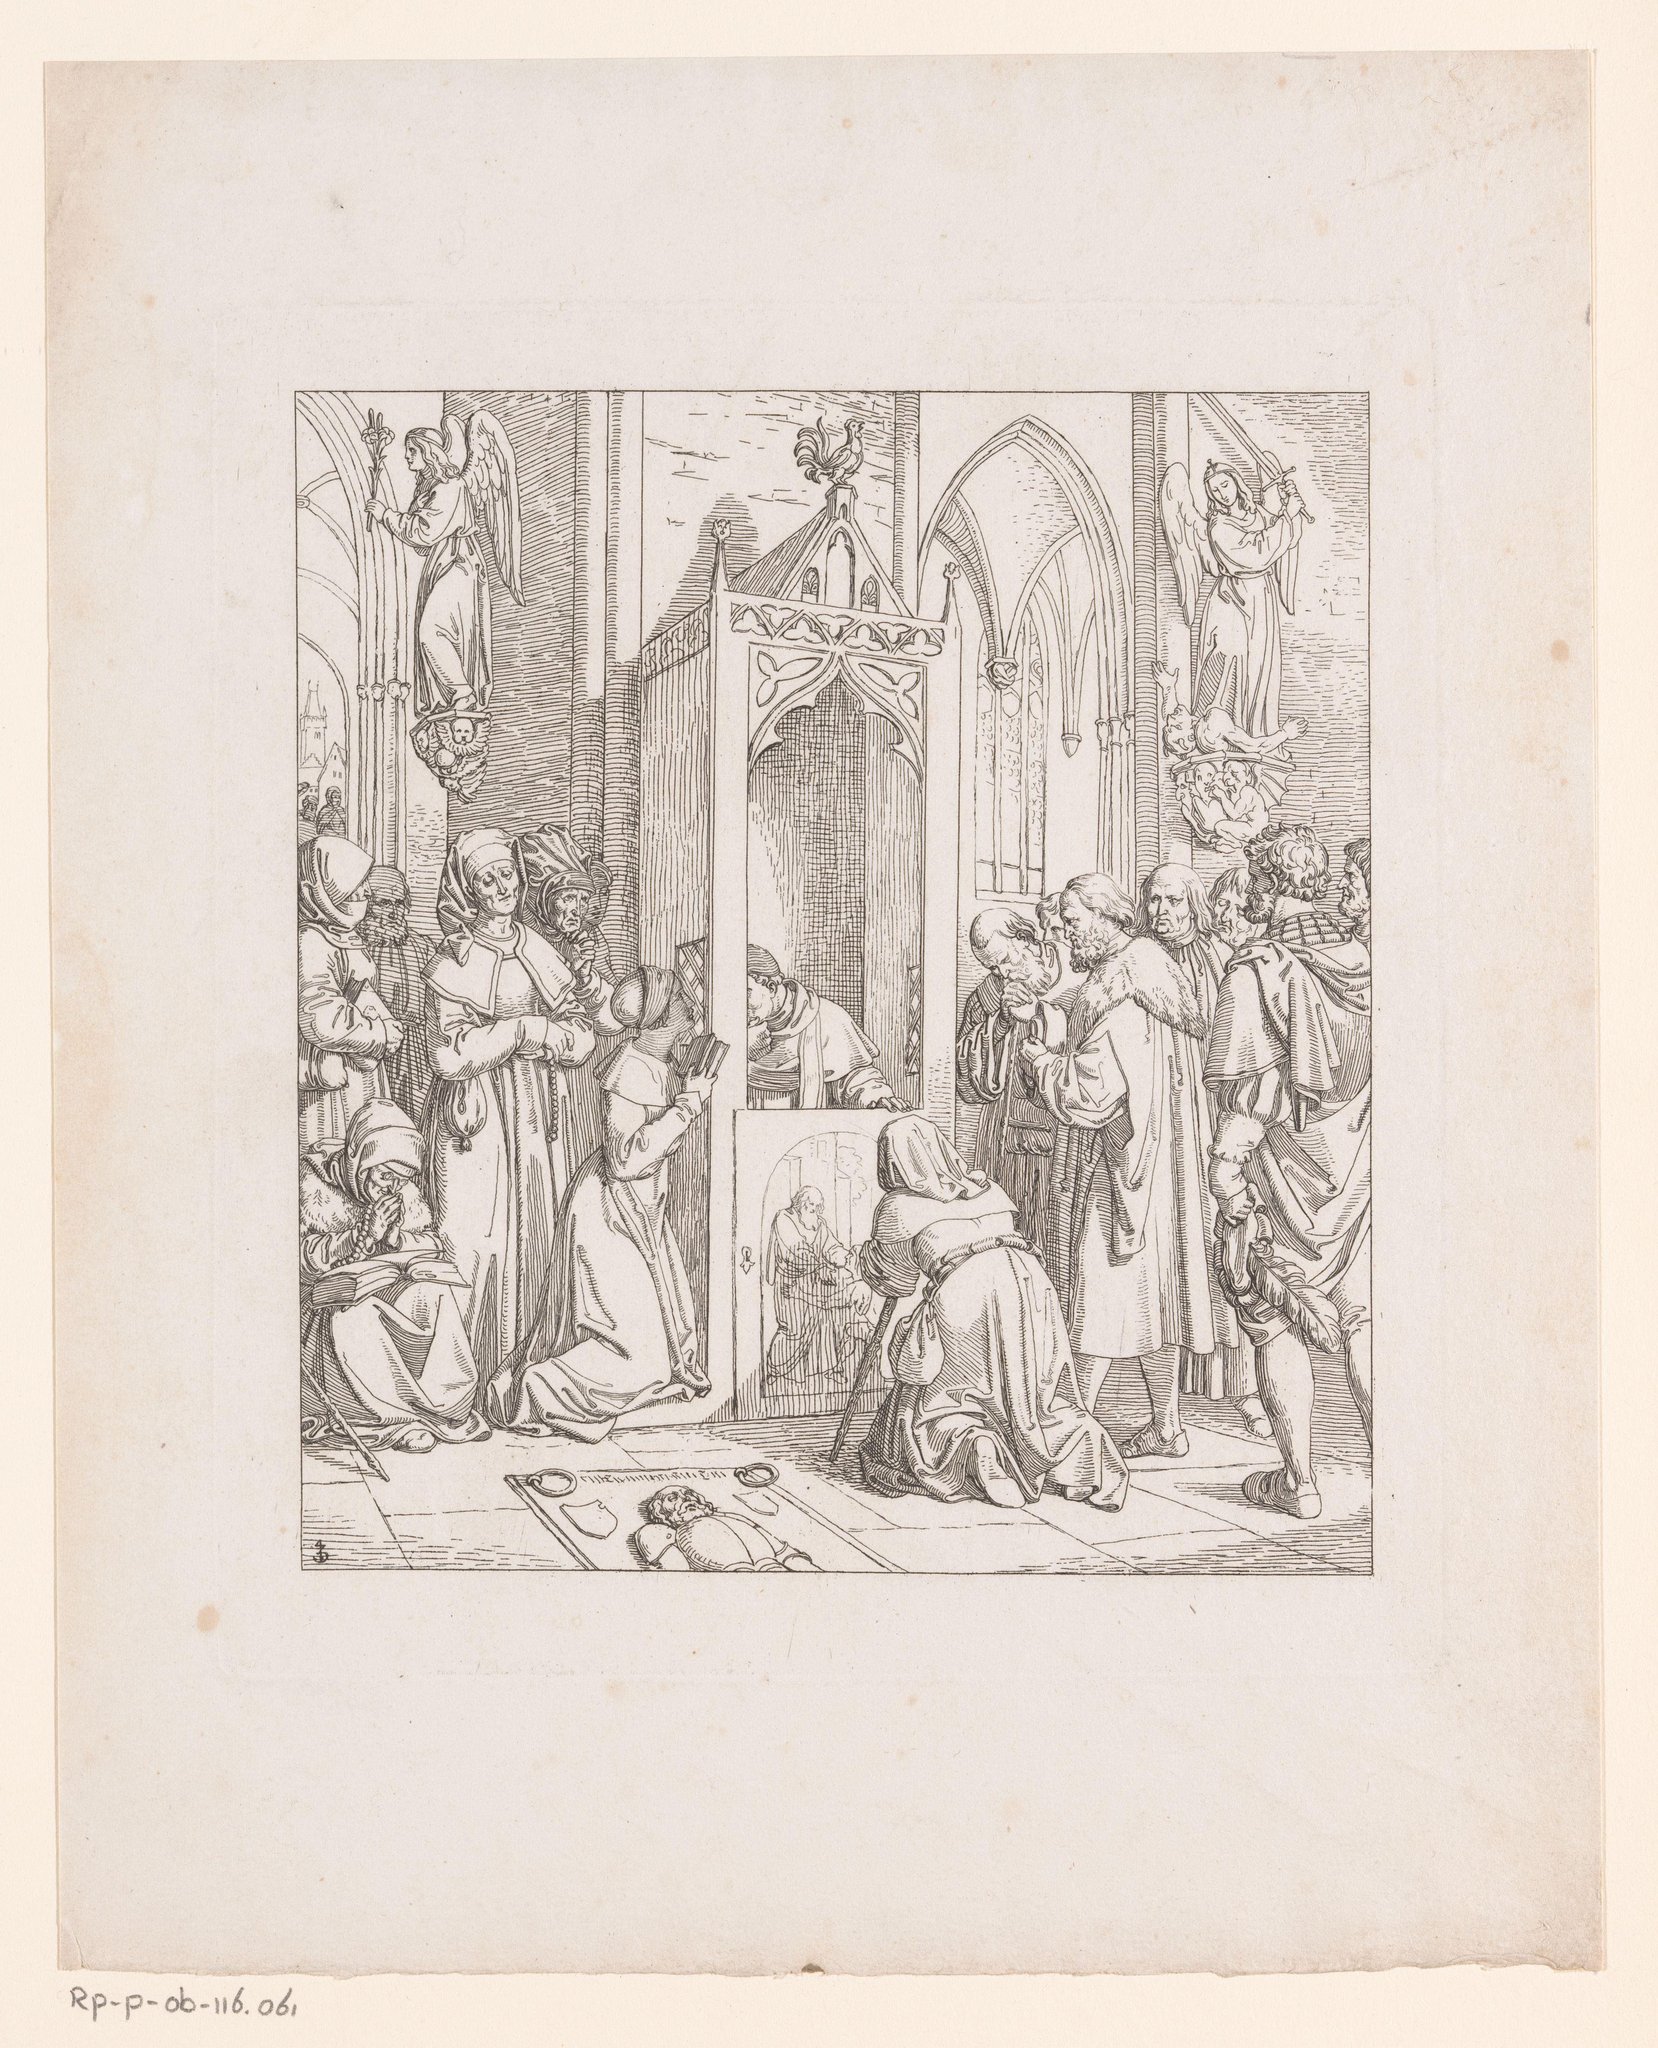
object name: print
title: Biechtende en biddende mensen rond de biechtstoel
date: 1840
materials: paper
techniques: etching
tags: the archangel michael (often in armour with sword or lance), (private) prayer; 'oratione', 'preghiere', 'preghiere a dio' (ripa), interior of church, confessional ~ part of the confession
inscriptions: collector's mark: Lugt 2228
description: Prent uit: Müller, Anton en Joseph von Führich. Das Vater Unser in neun Blättern. Praag: Peter Bohmanns Erben, 1840.